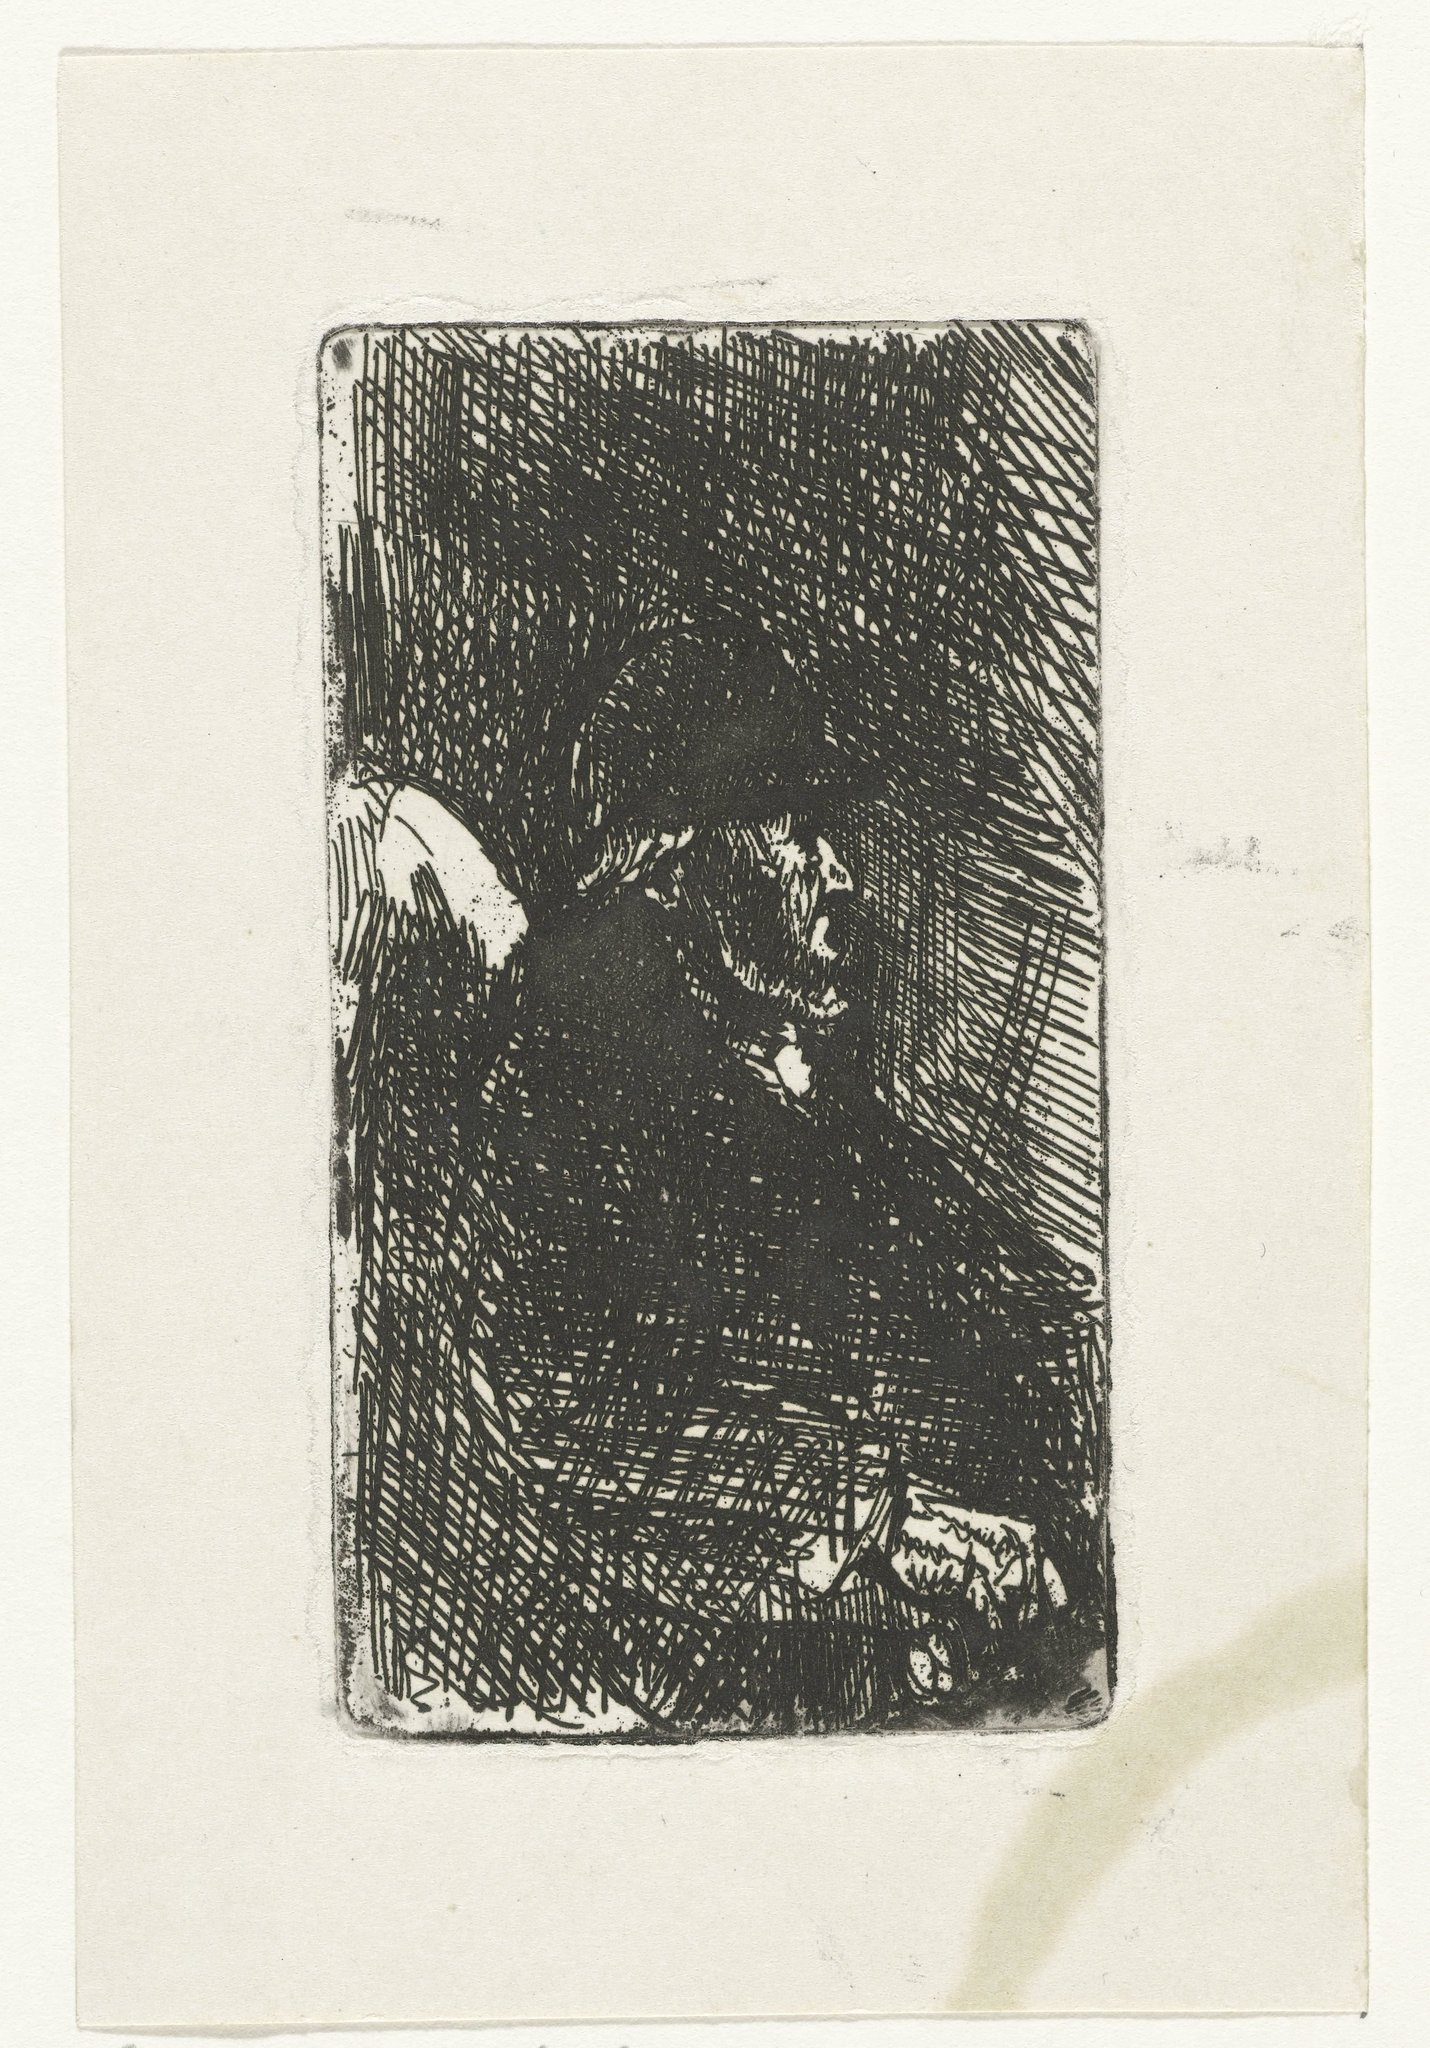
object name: print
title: Zittende oude man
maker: jozef israëls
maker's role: draughtsman, painter, print maker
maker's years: 1824-1911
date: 1835-1888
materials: paper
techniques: etching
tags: sitting figure, head-gear: cap (+ men's clothes), old man (+ sideview, profile)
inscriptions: collector's mark: Lugt 2228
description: Buste van een zittende oude man met een pet op het hoofd, en profil naar rechts.